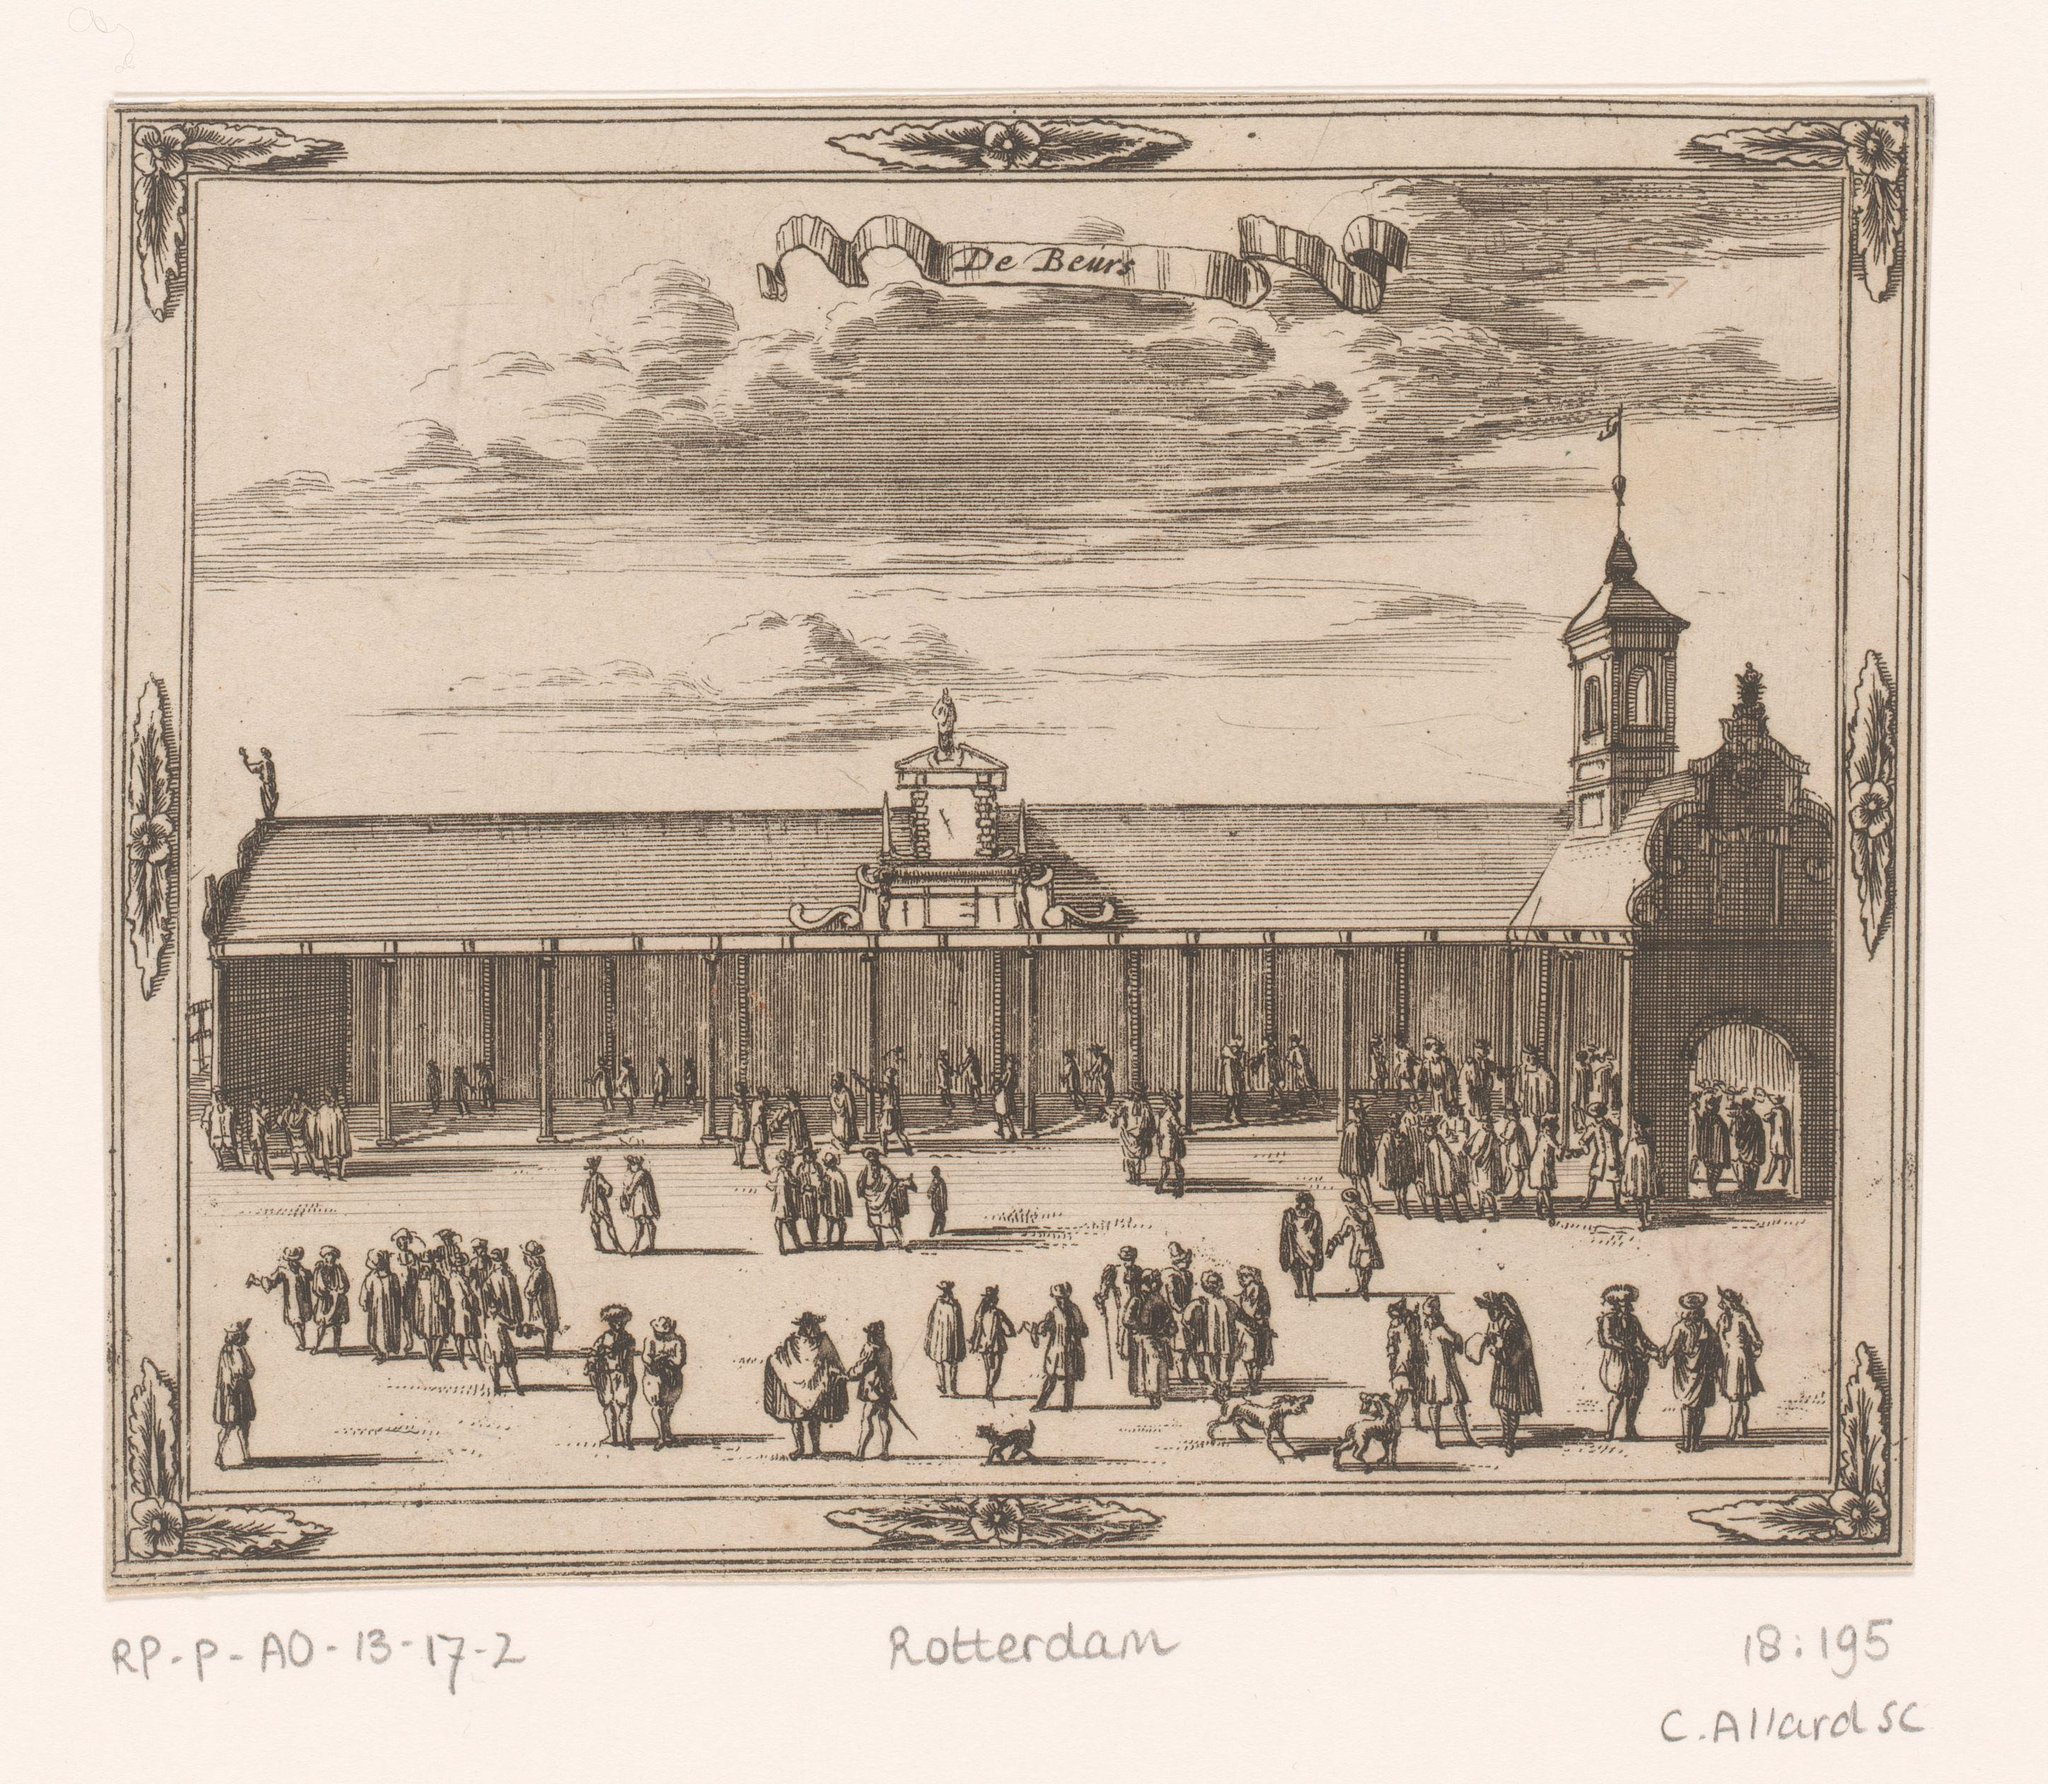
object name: print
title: Gezicht op de Beurs te Rotterdam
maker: jacobus harrewijn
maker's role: print maker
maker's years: 1660-1740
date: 1715-1730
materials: paper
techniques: etching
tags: stock exchange, stock-market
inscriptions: collector's mark: Lugt 2228, collector's mark: Lugt 195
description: Prent vermoedelijk eerst met dertien andere stadsgezichten uitgegeven als onderdeel van de sierrand van – in ieder geval de derde staat en mogelijk ook de tweede van – de plattegrond 'Tabula Roterodami Novissima' (zie RP-P-AO-13-11). Later nog een keer als onderdeel van een prentserie uitgegeven: Les principaux edifices et vues de la ville de Rotterdam. Le tout fidèlement dessiné sur les lieux. Leiden: Pieter van der Aa, s.a. [adres 'dans l'Academie', dus 1715-1730]. De platen zijn voor zover na te gaan ongewijzigd gebleven.